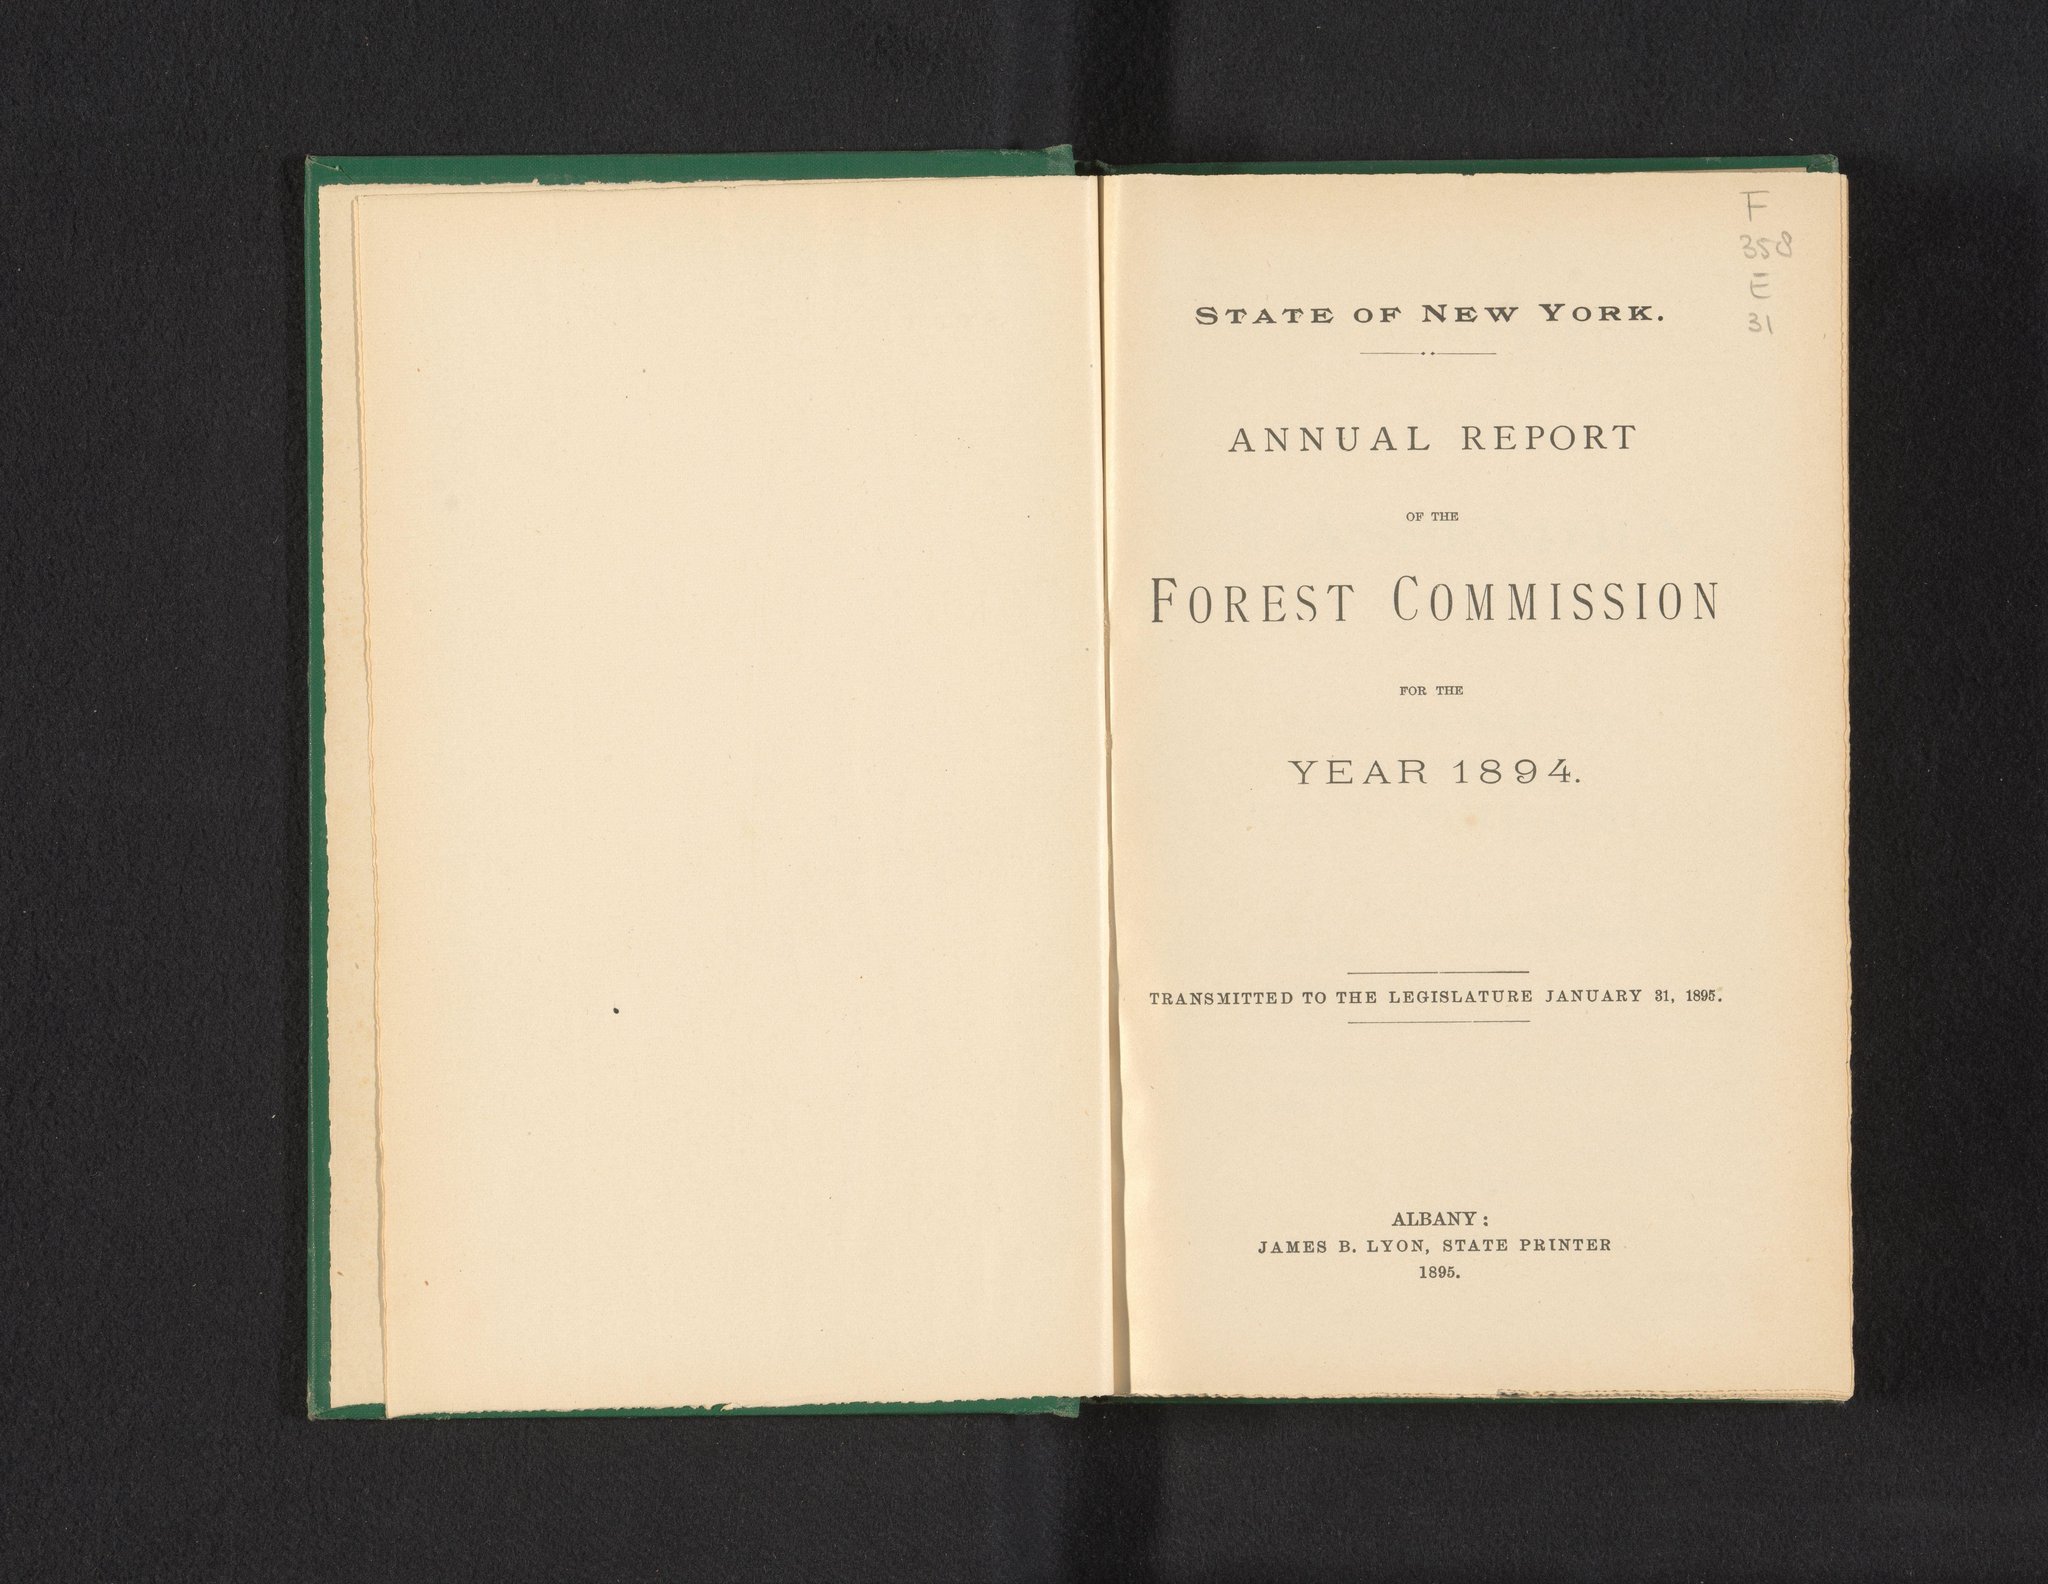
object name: book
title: Annual report of the Forest Commission of the State of New York for the year ending December 31, 1894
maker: james b. lyon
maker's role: printer, publisher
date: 1895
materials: cardboard, linen, paper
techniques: photograph, printing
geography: new york city